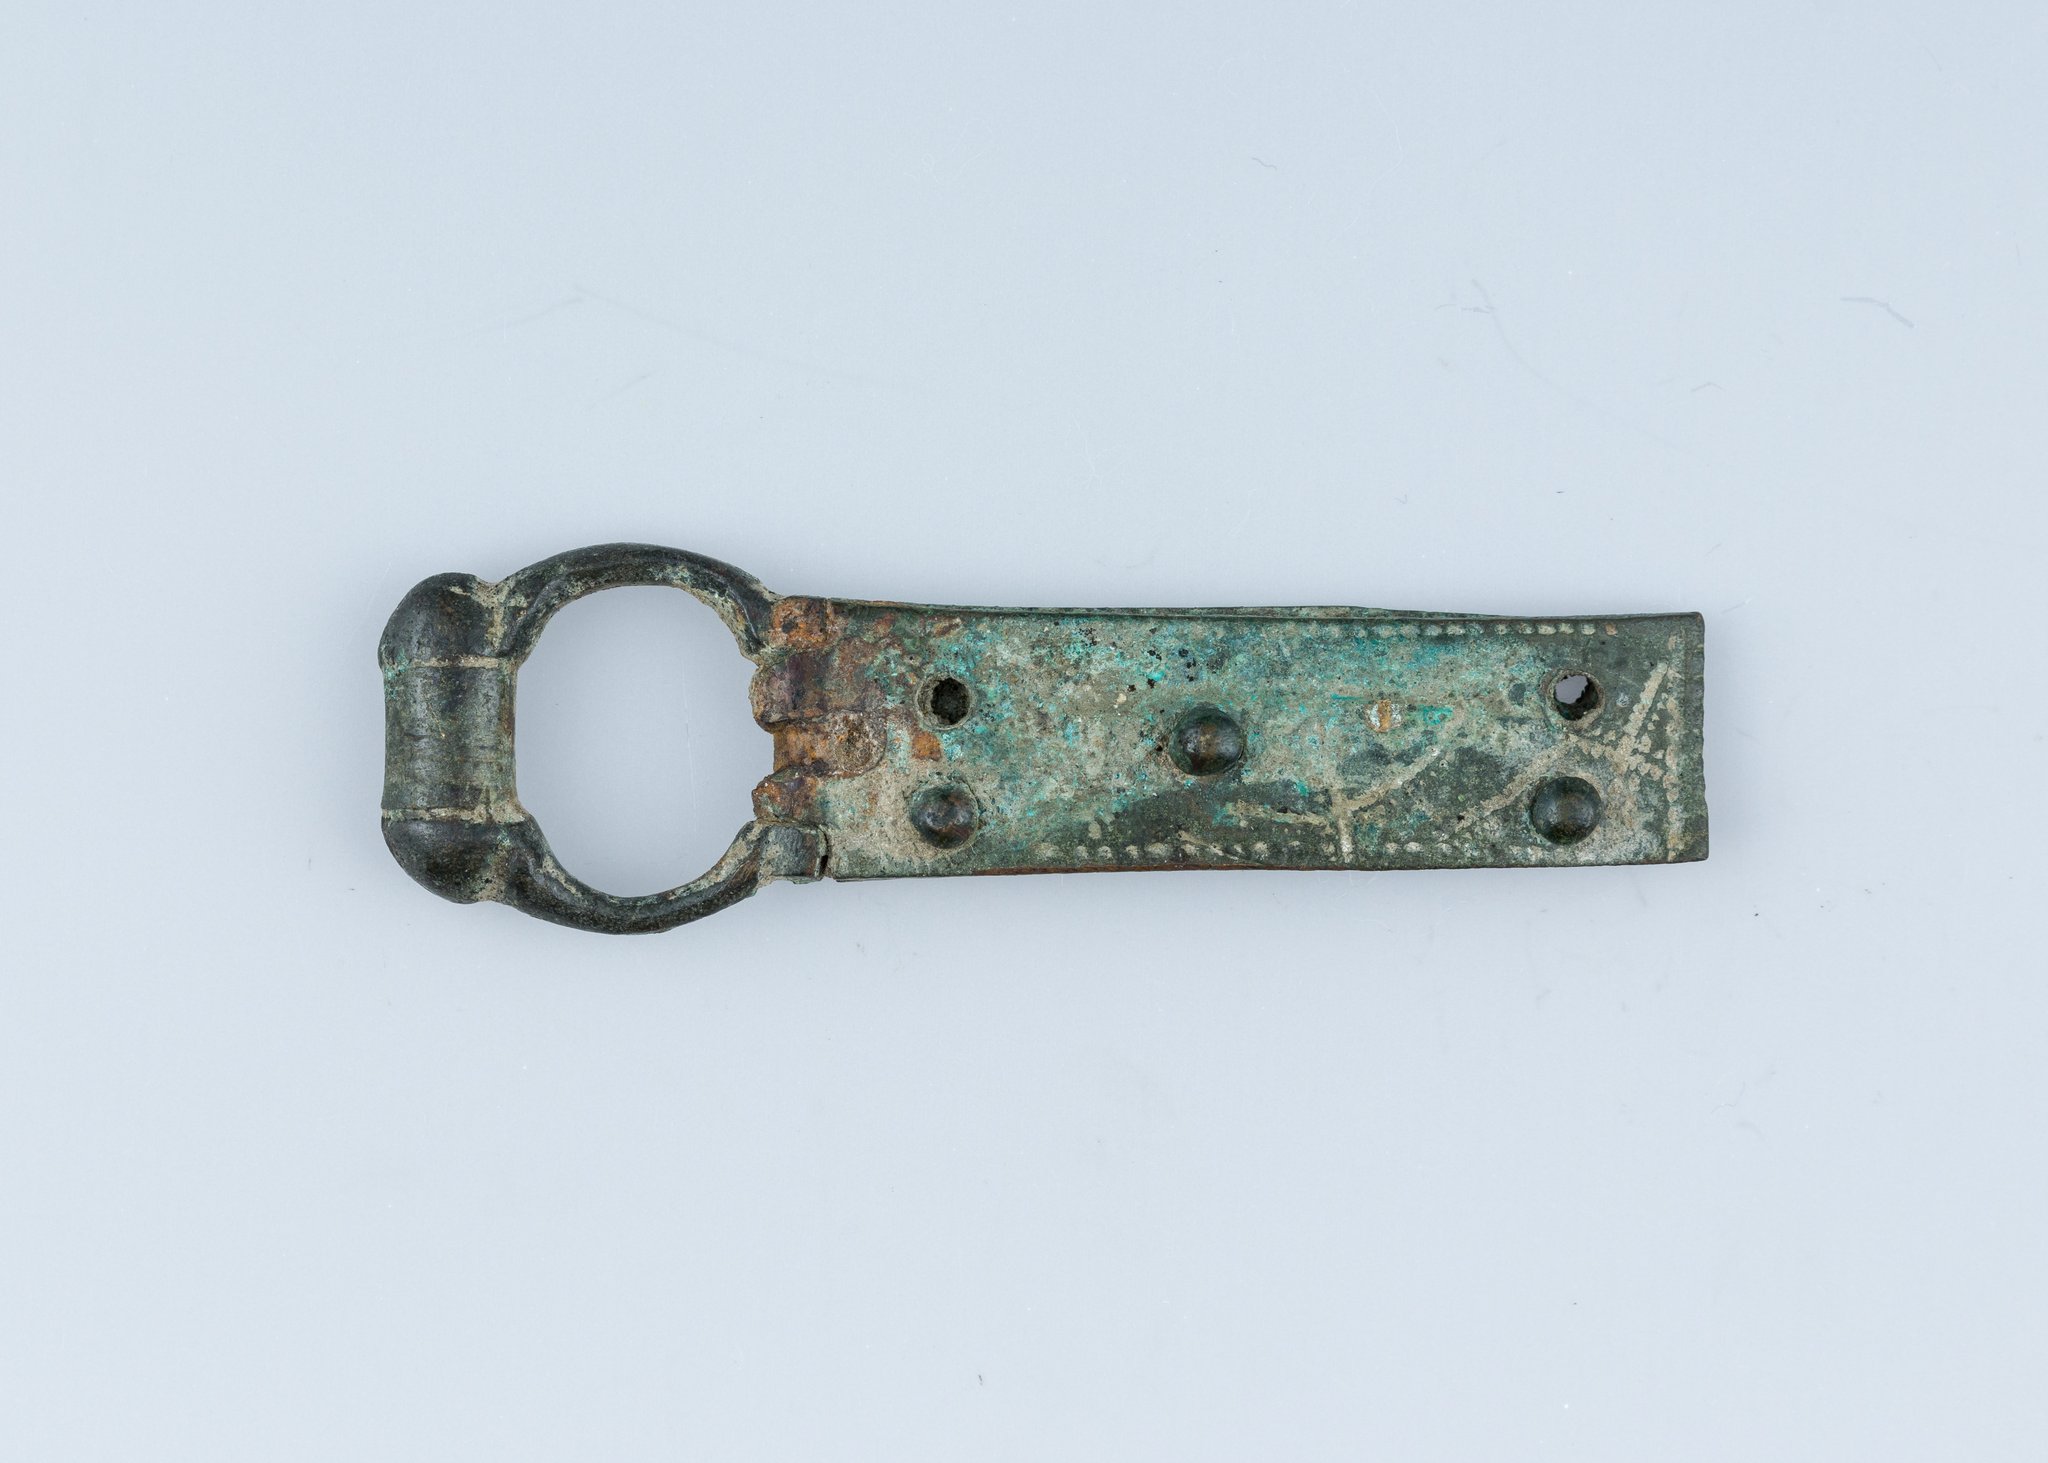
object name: buckle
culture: french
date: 1301-1400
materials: bronze, patina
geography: france